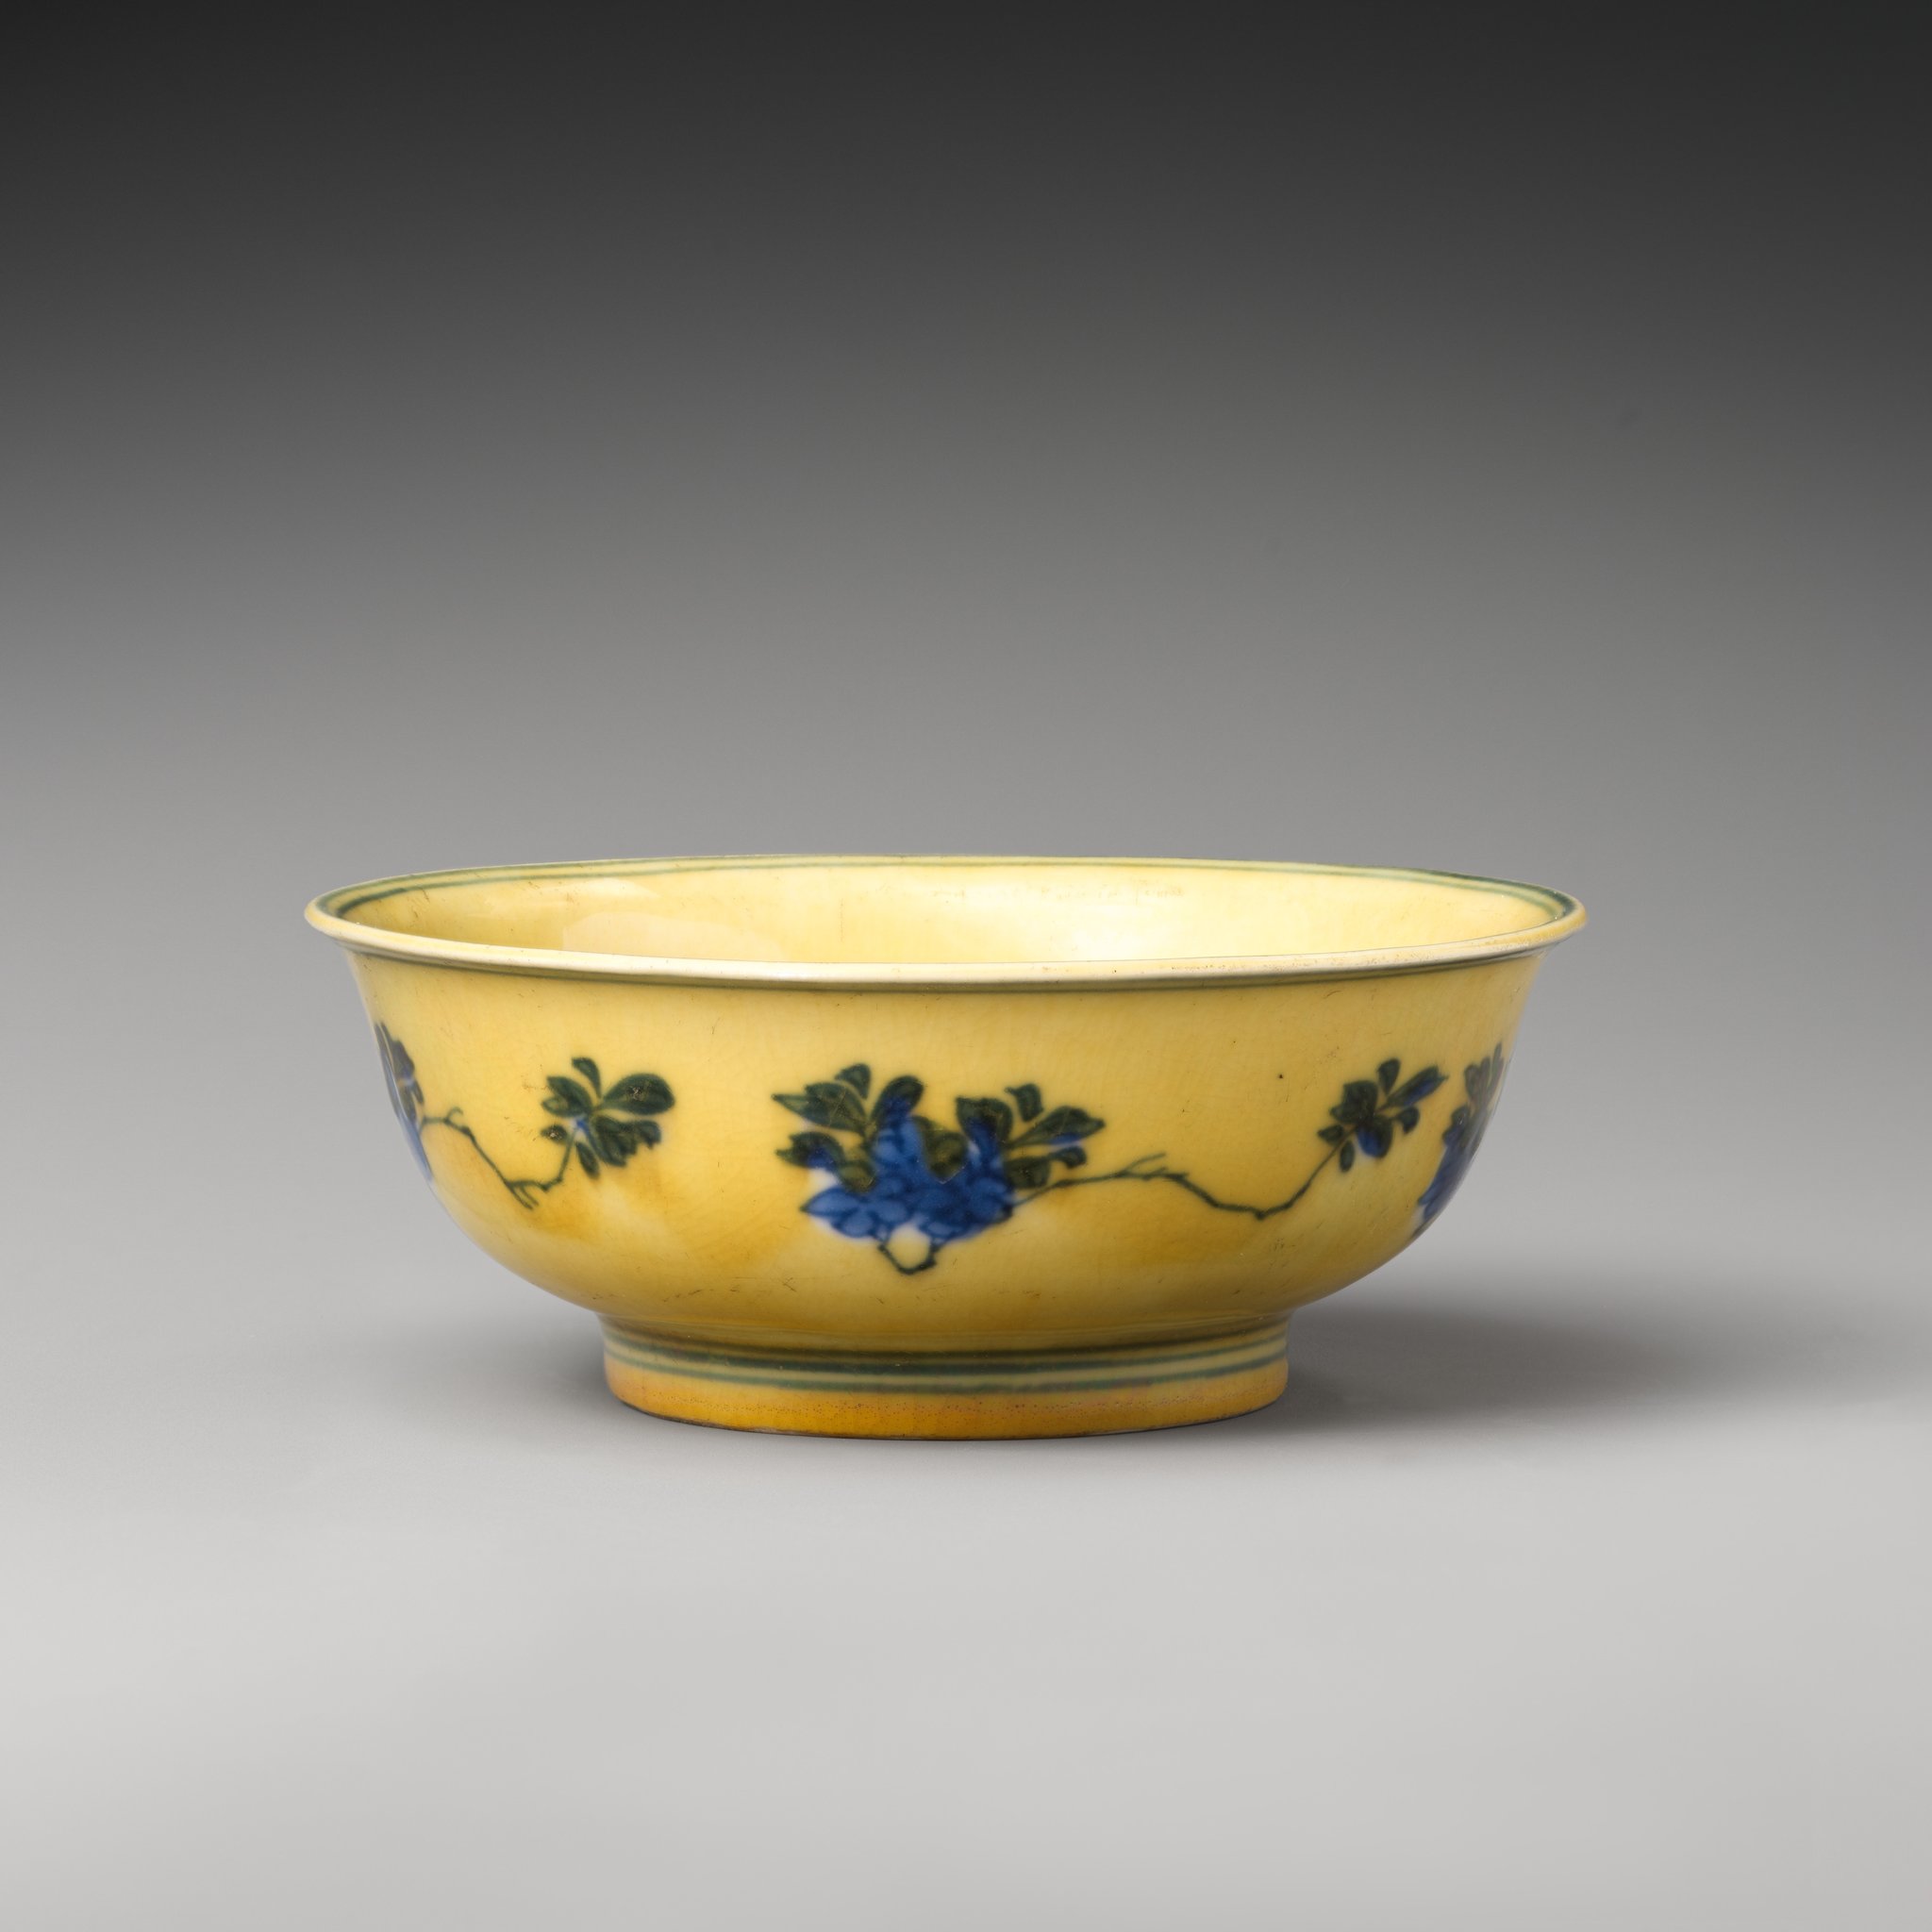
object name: bowl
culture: chinese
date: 1662-1722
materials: enamel, porcelain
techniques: overglaze, painting, underglaze